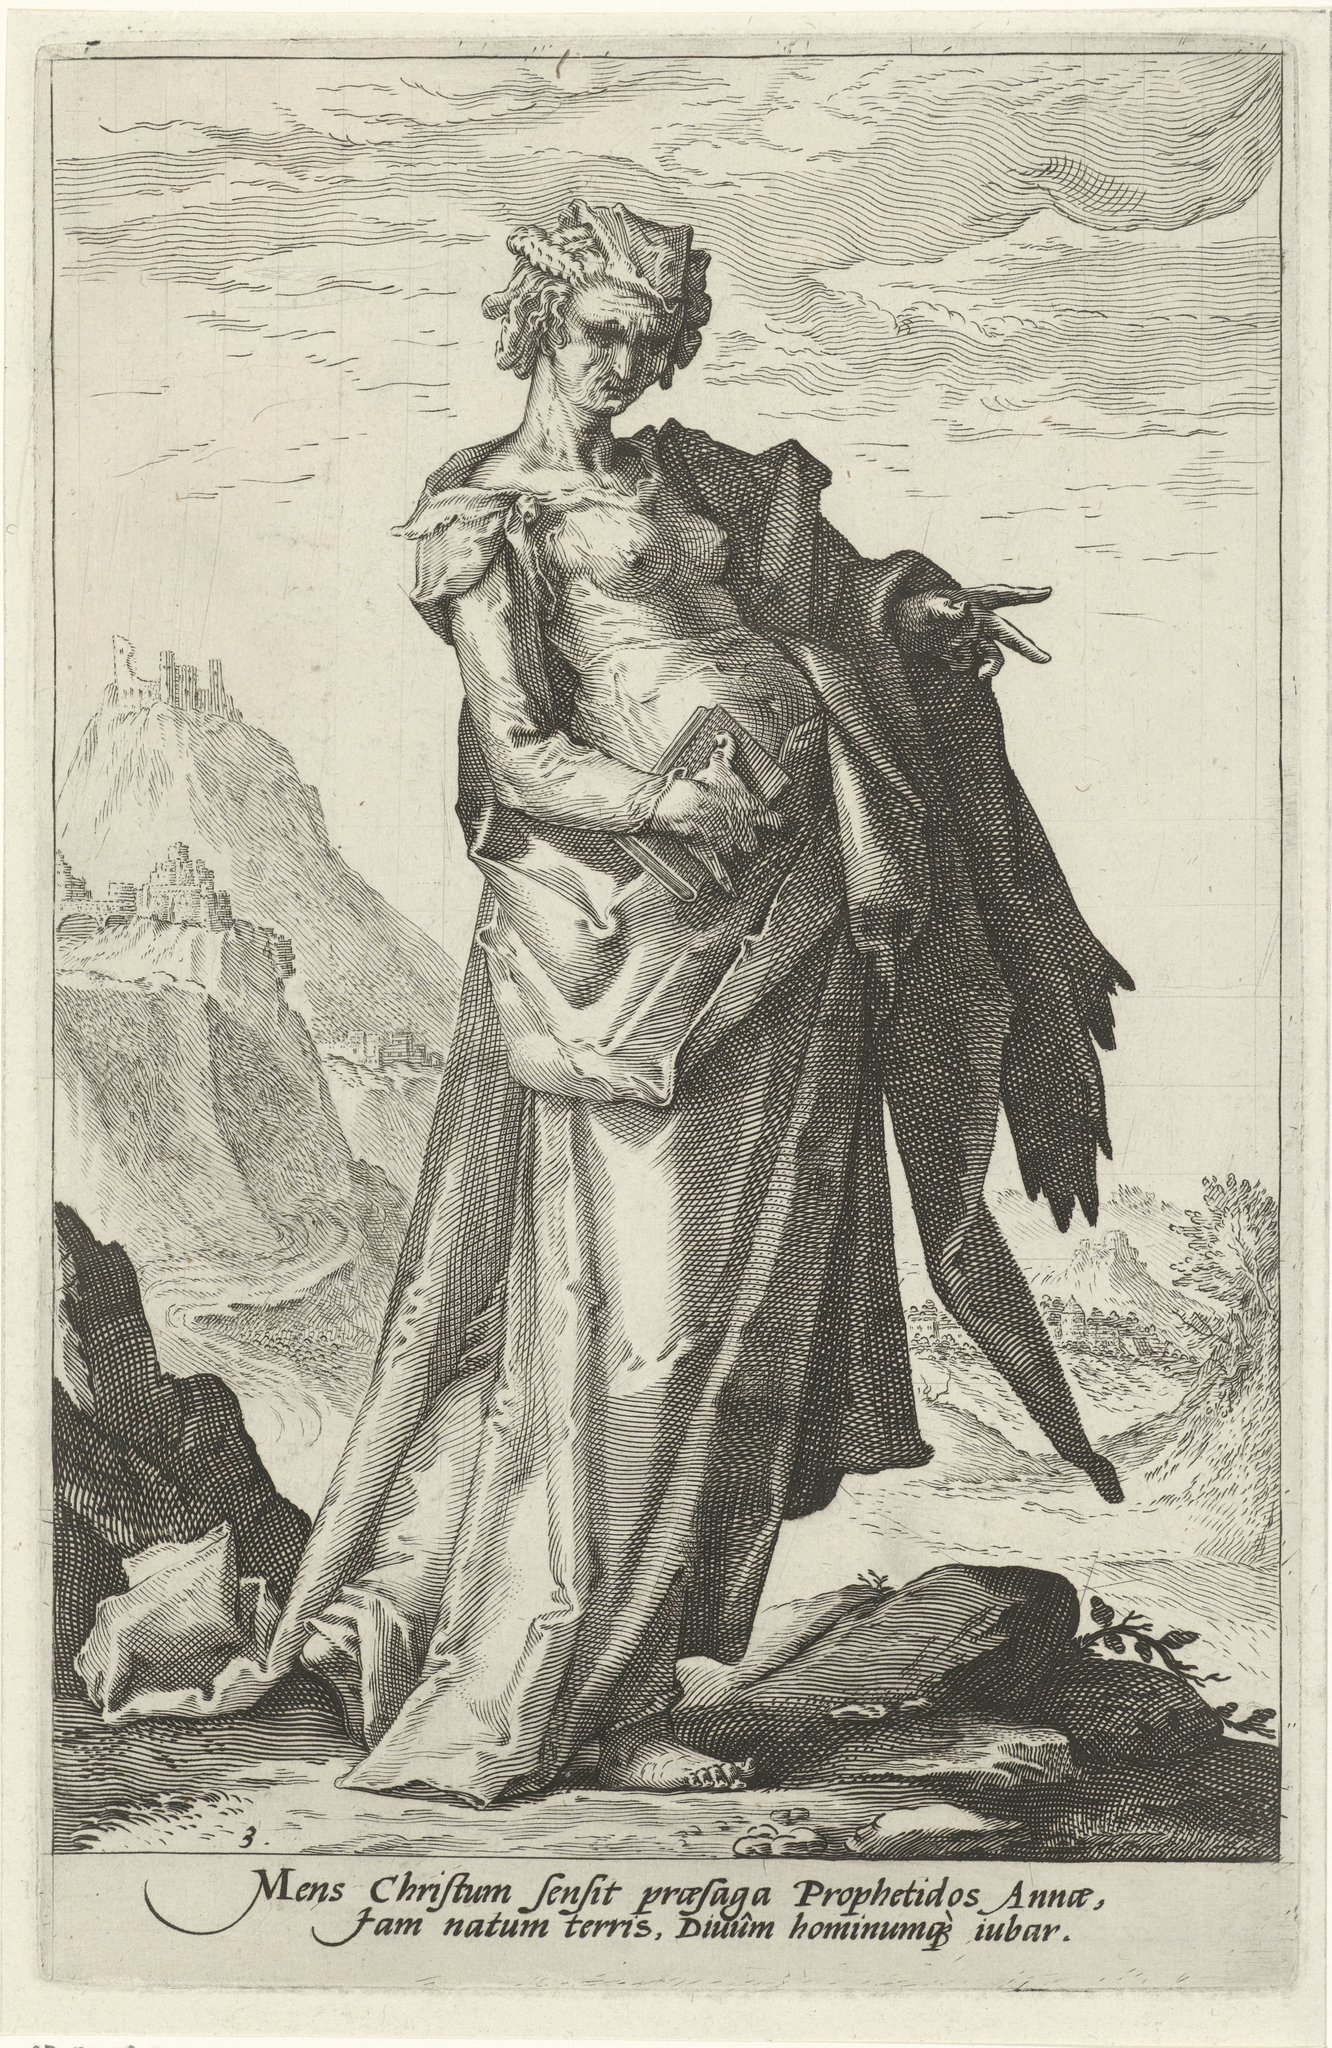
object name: print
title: Profetessen van het Oude Testament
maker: jacob matham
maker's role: draughtsman, print maker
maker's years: 1571-1631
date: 1588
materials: paper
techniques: engraving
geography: haarlem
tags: female persons from the old testament (with name) (not in biblical context)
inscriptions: collector's mark: Lugt 2228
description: De profetes Hannah, staand in een landschap.